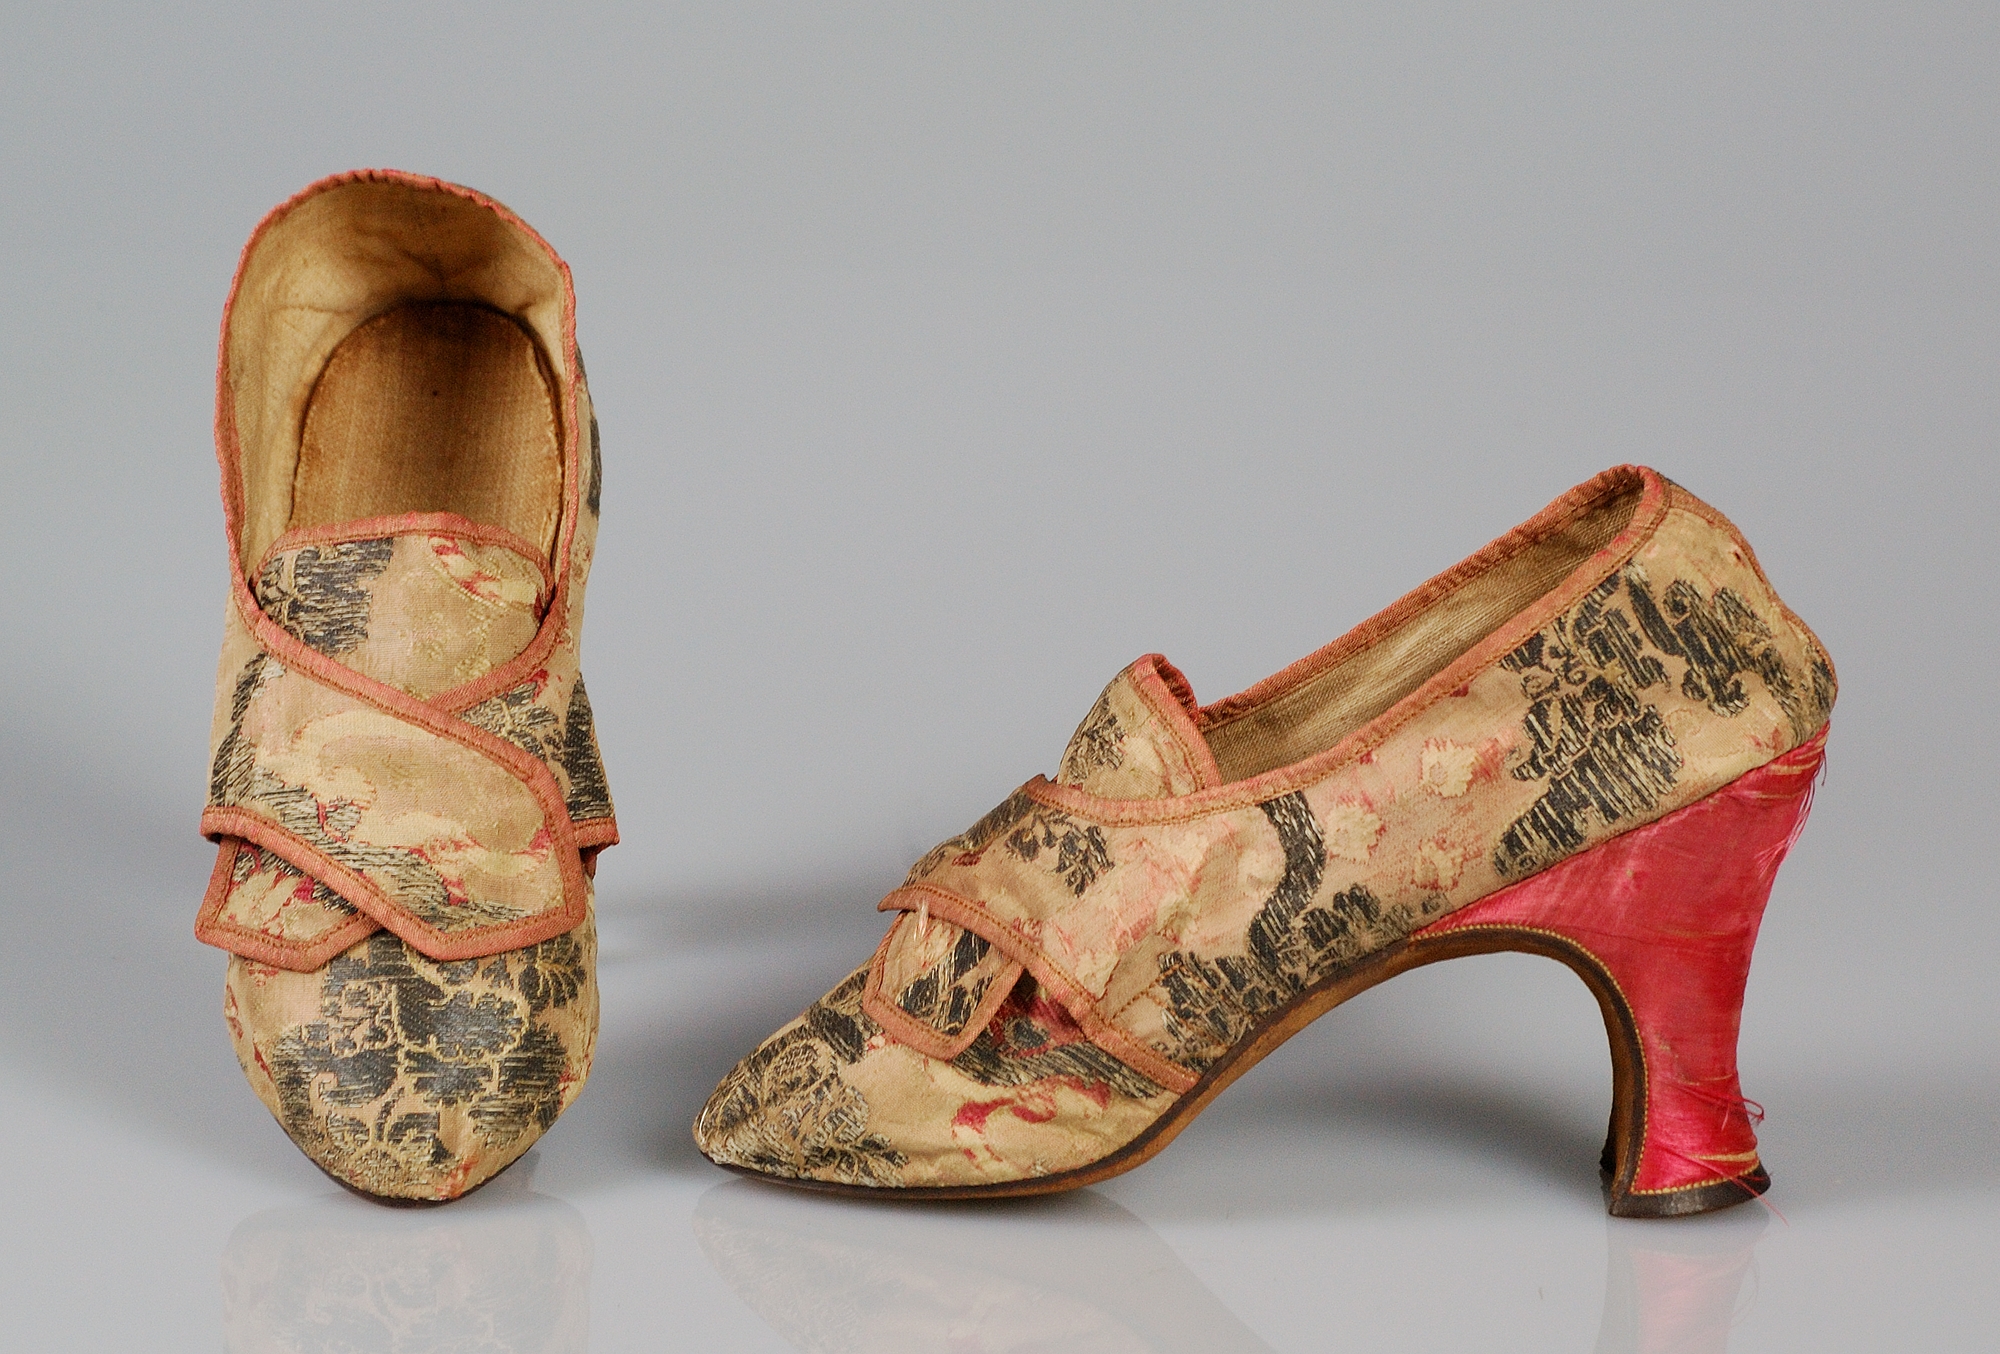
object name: shoe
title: Shoes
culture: french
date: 1760-1775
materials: silk